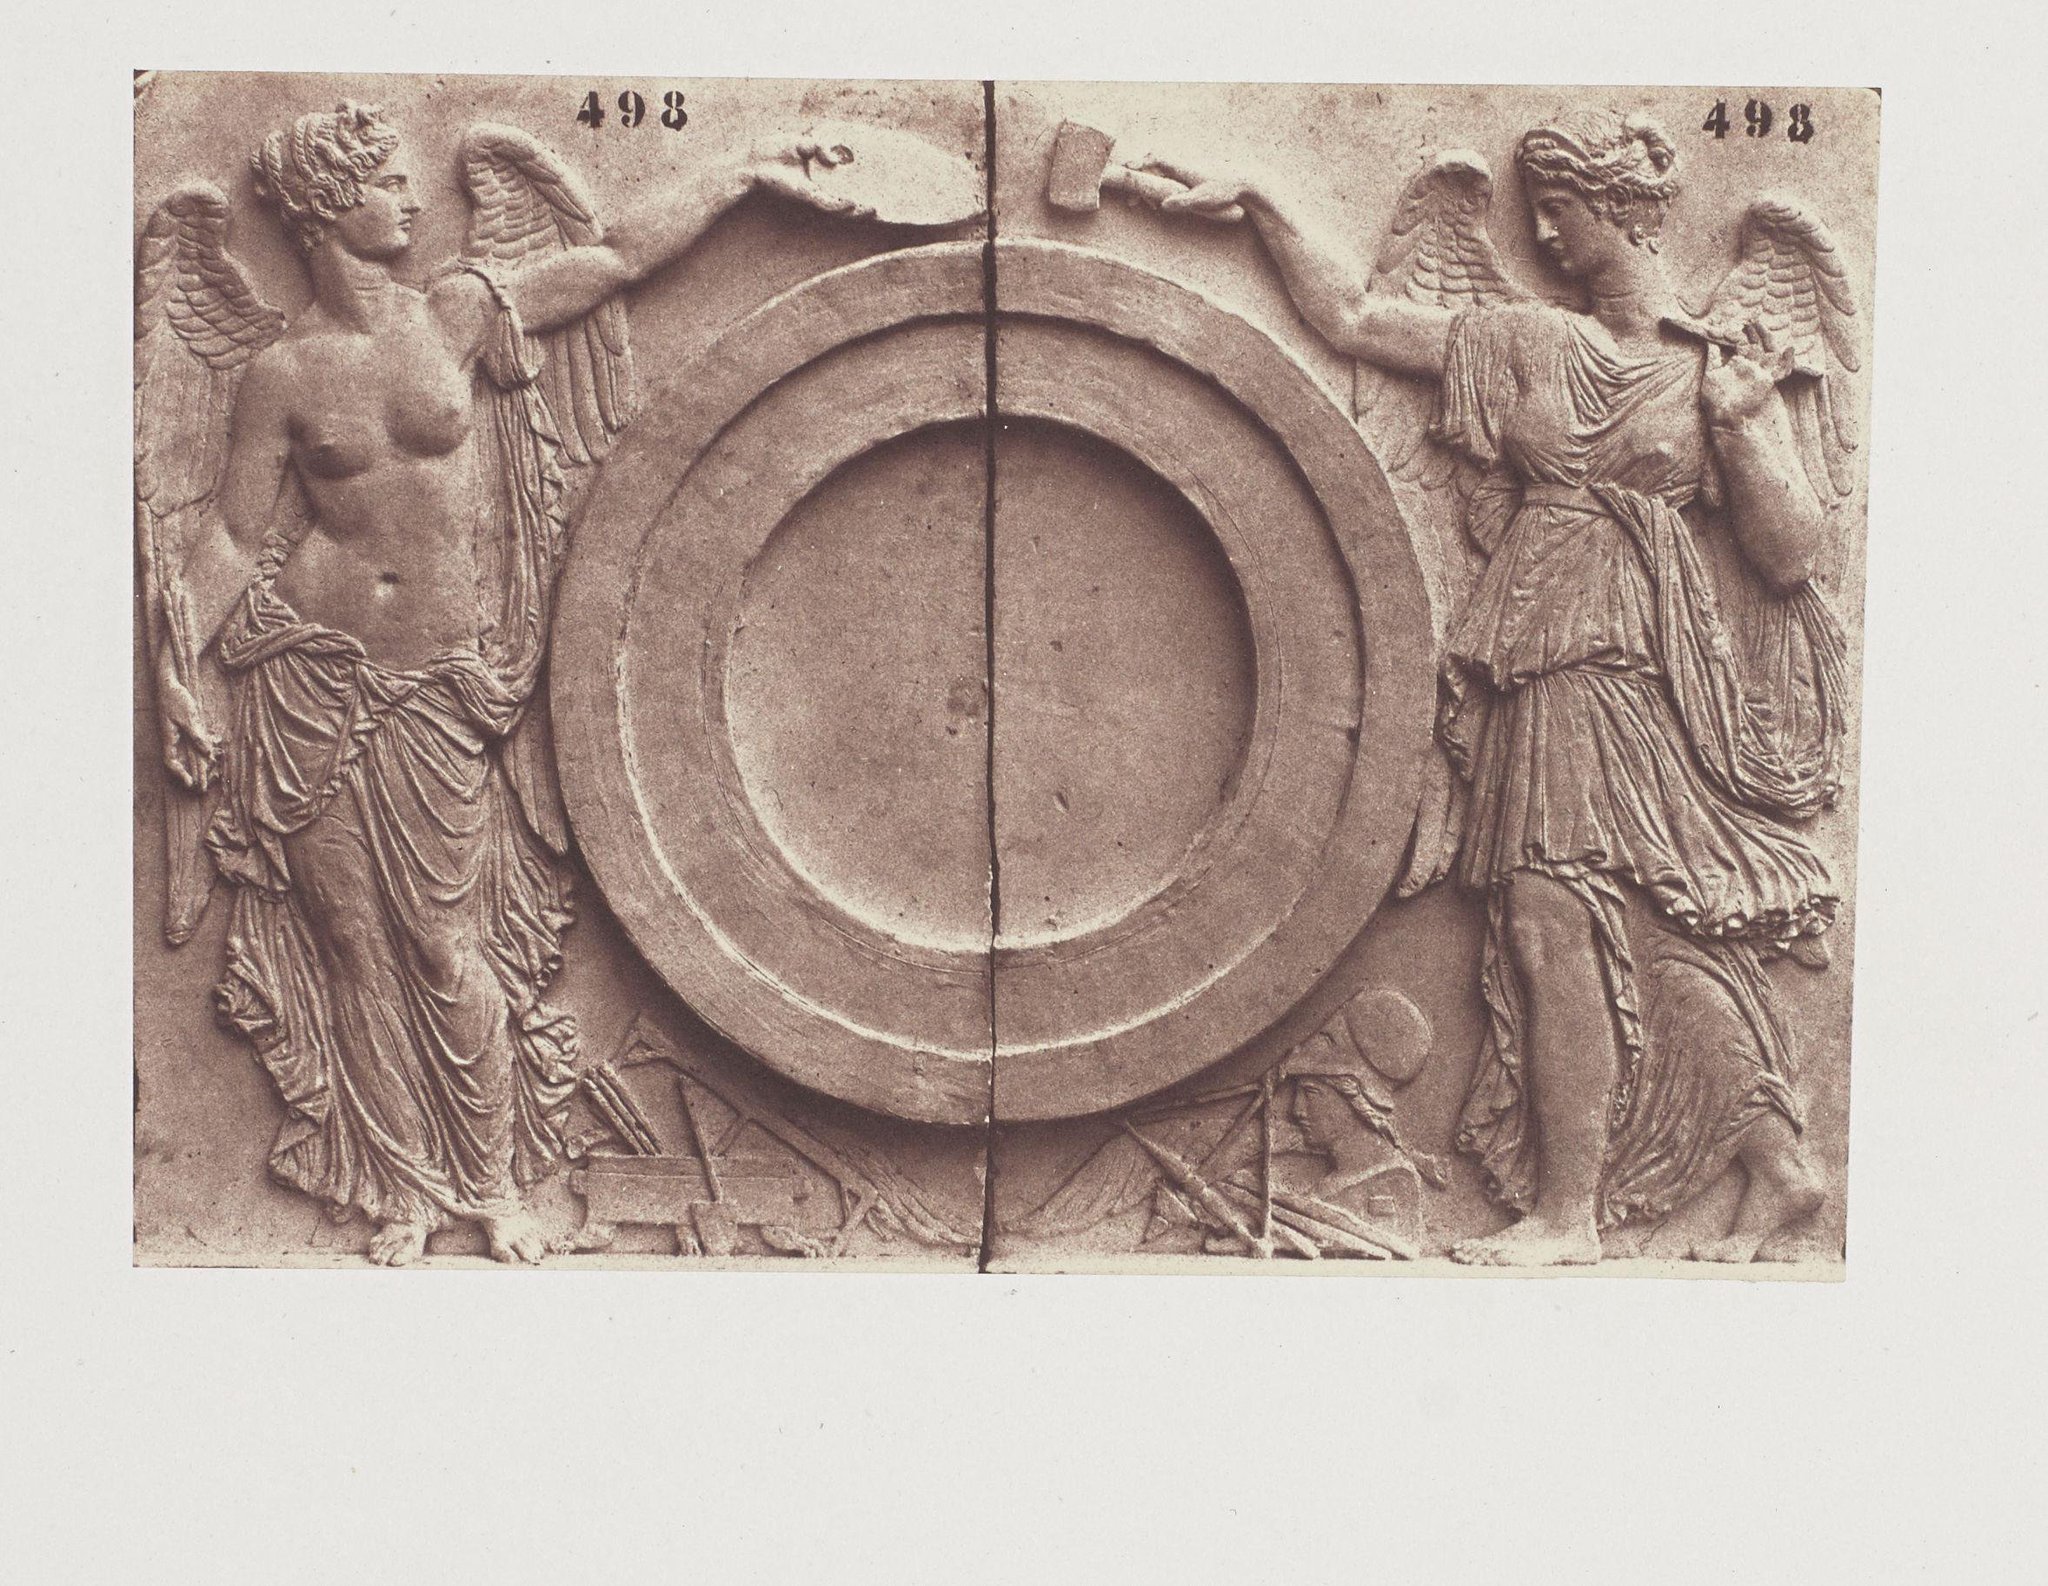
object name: album leaf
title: Gipsmodellen voor beeldhouwwerken op het Palais du Louvre: "La Gravure et l'Architecture" door Eugène Louis Lequesne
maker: édouard denis baldus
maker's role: fotograaf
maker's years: 1813-1889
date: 1855-1857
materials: paper, photographic support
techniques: salted paper print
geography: paris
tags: piece of sculpture, reproduction of a piece of sculpture, permanent exhibition, museum, paris, tuileries palace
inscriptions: number: ‘498’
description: Onderdeel van Réunion des Tuileries au Louvre 1852-1857, album 2.